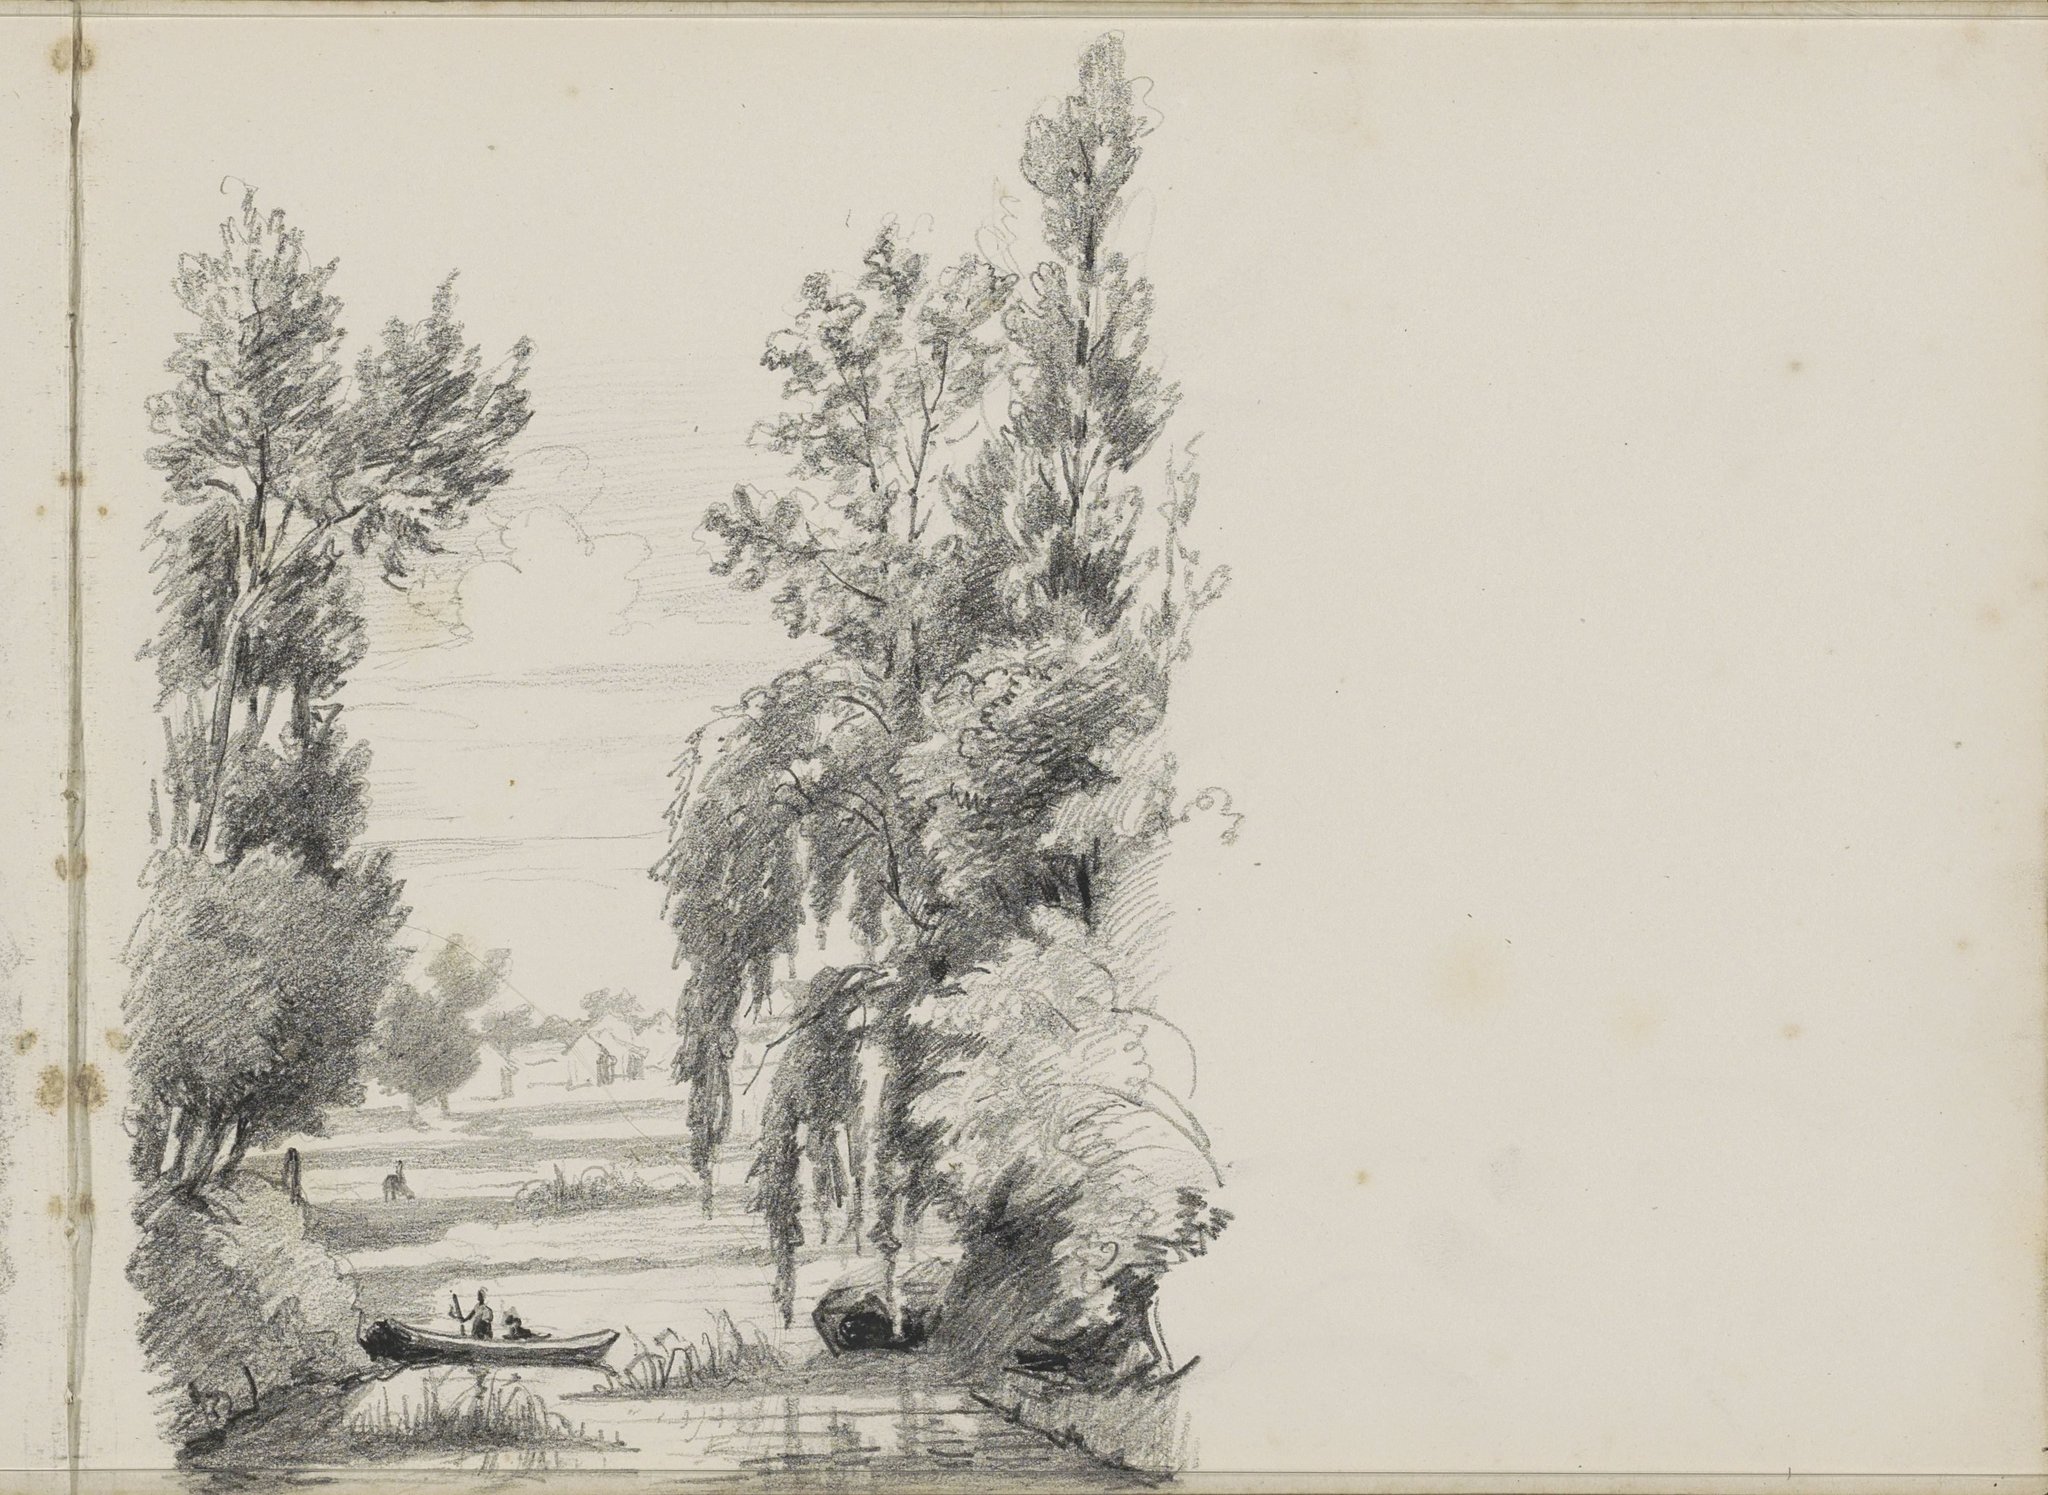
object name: sketchbook leaf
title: Rivierlandschap bij Sainte-Maure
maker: gerrit postma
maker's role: draughtsman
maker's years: 1819-1894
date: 1858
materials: paper, pencil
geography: sainte-maure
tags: river, rowing-boat, canoe, etc.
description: Blad 15 recto uit een schetsboek met 52 bladen.